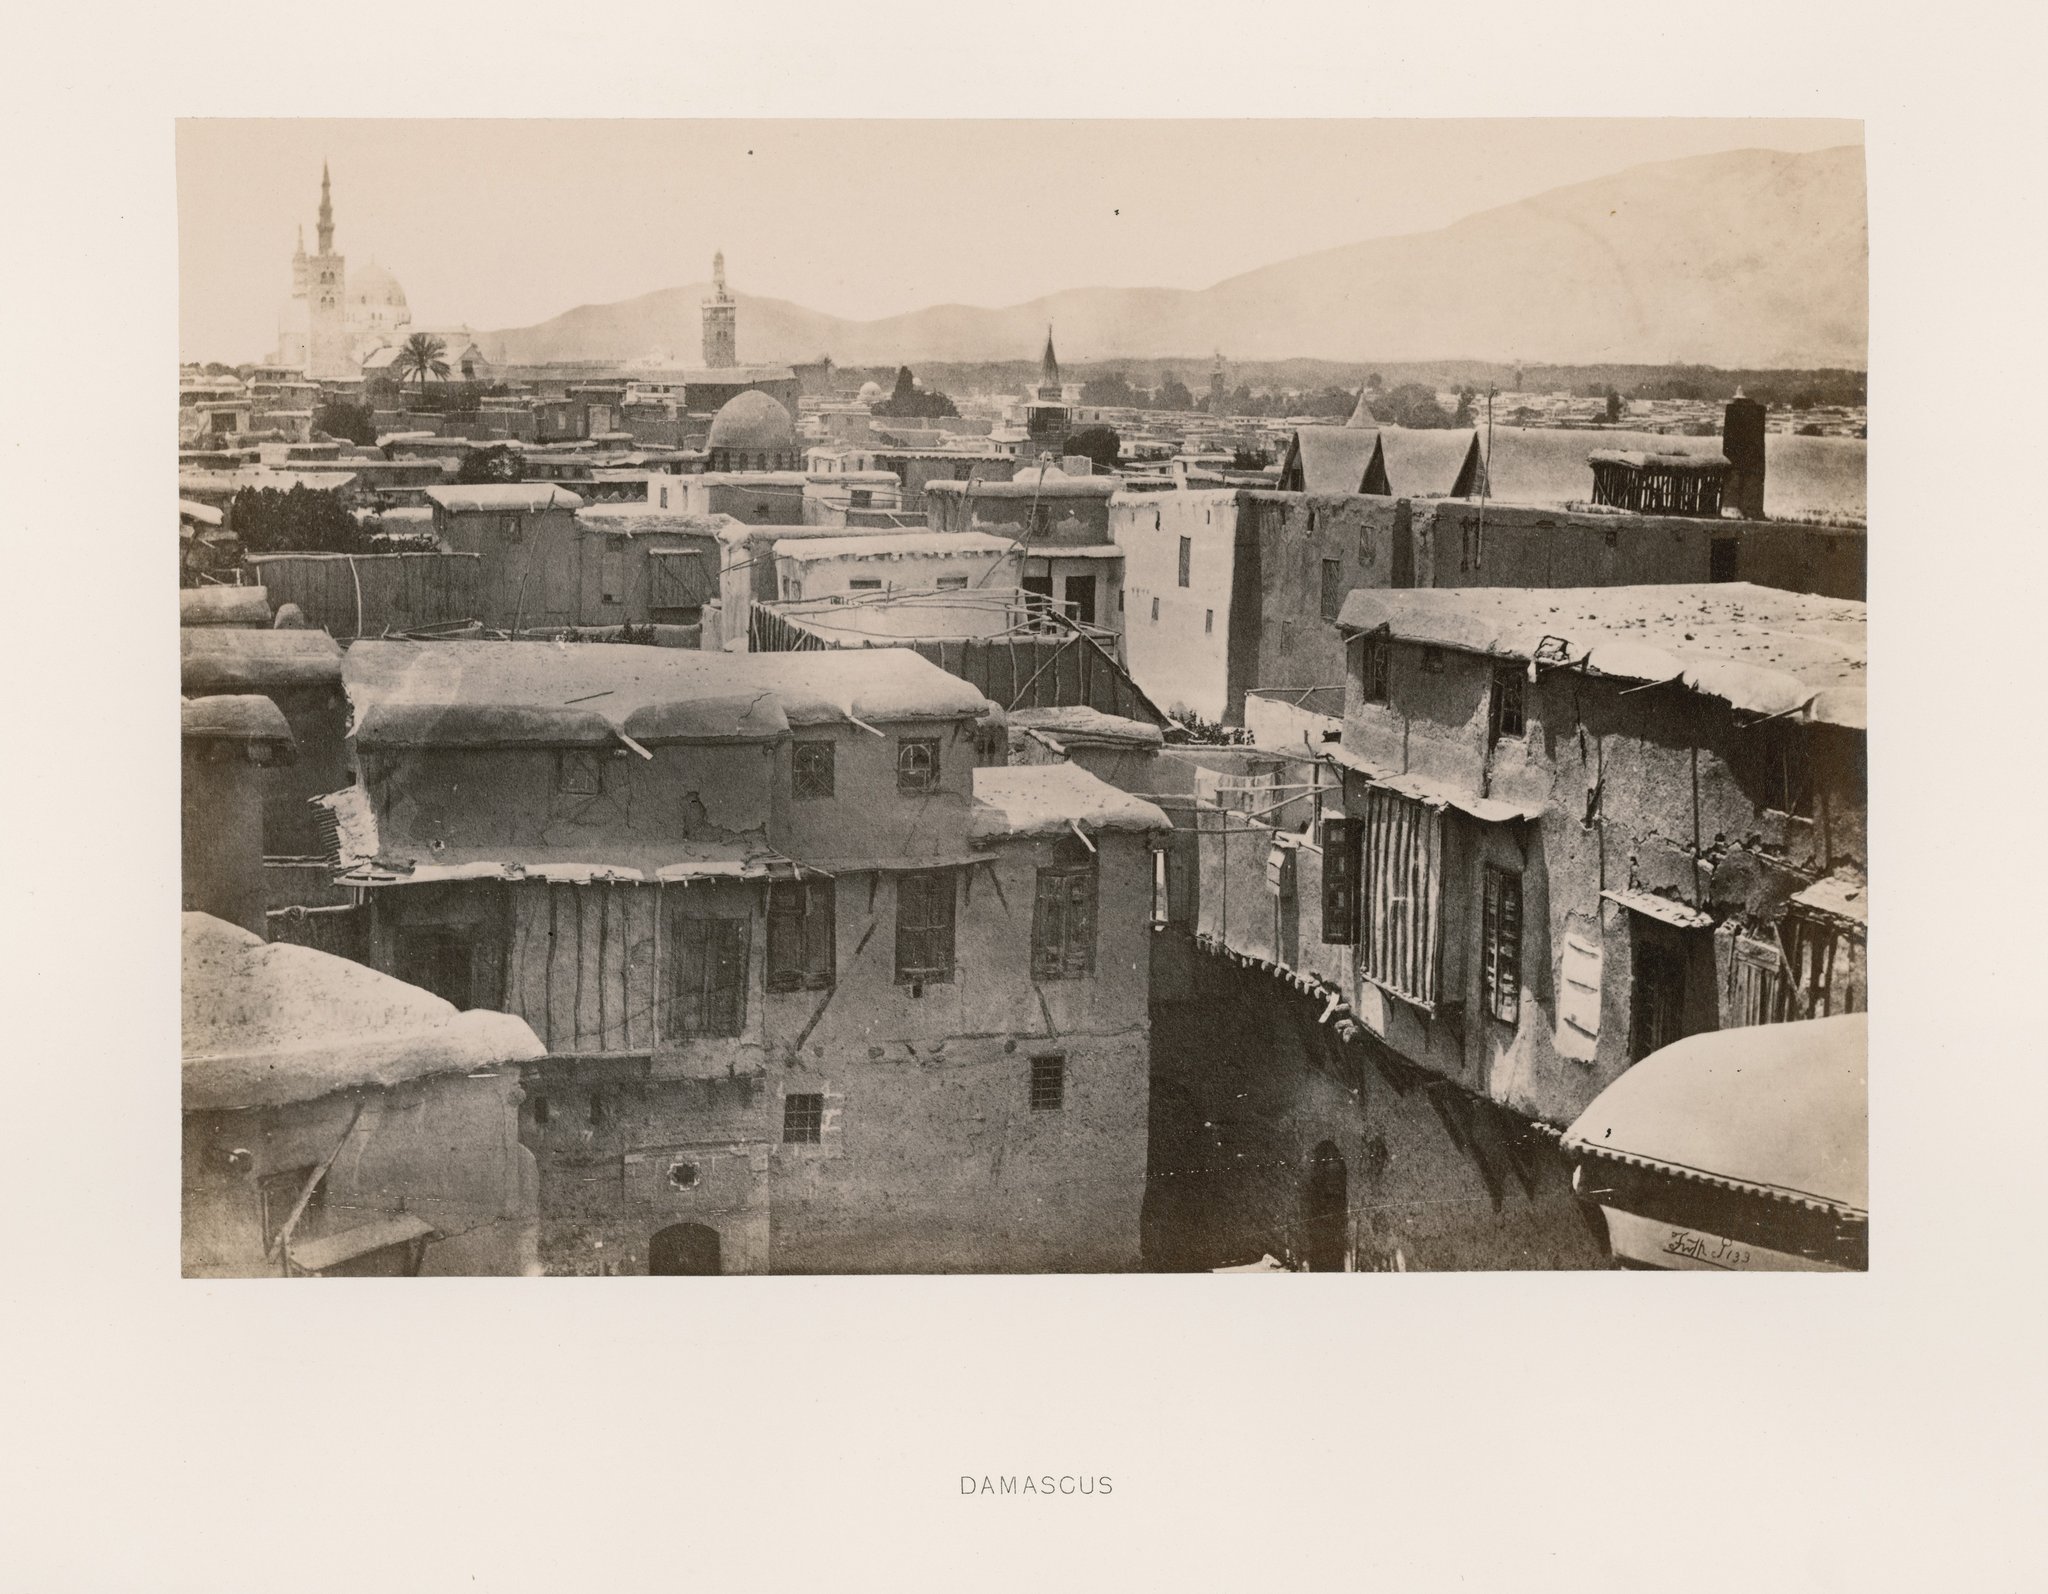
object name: photographically illustrated book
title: Egypt, Sinai and Palestine. Supplementary Volume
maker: francis frith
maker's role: publisher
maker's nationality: english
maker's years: 1822-1898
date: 1860-1869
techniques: albumen silver print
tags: cities